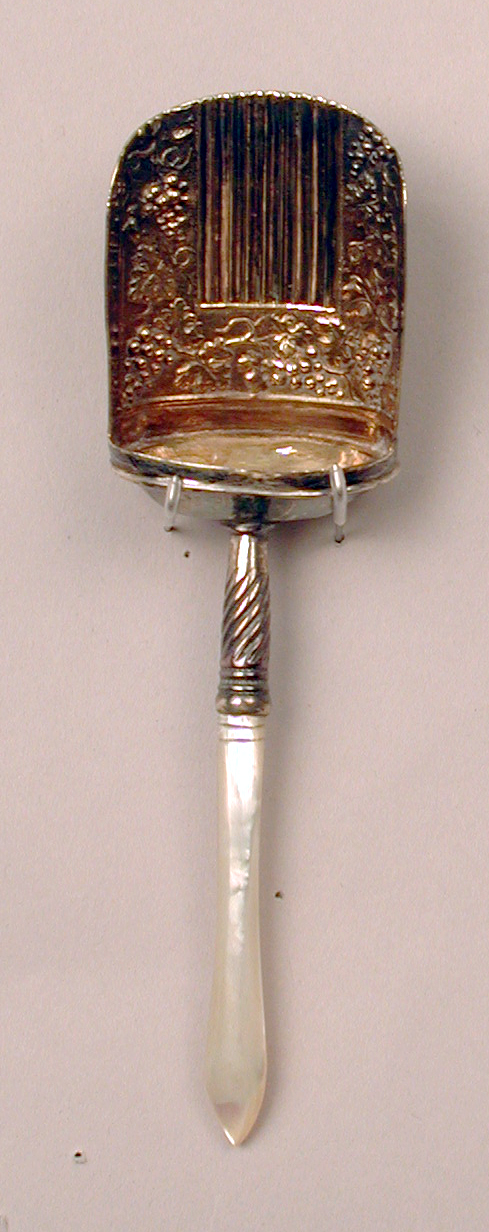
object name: scoop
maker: samuel pemberton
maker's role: maker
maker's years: 1750-1850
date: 1813-1814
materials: gilt, mother of pearl, silver